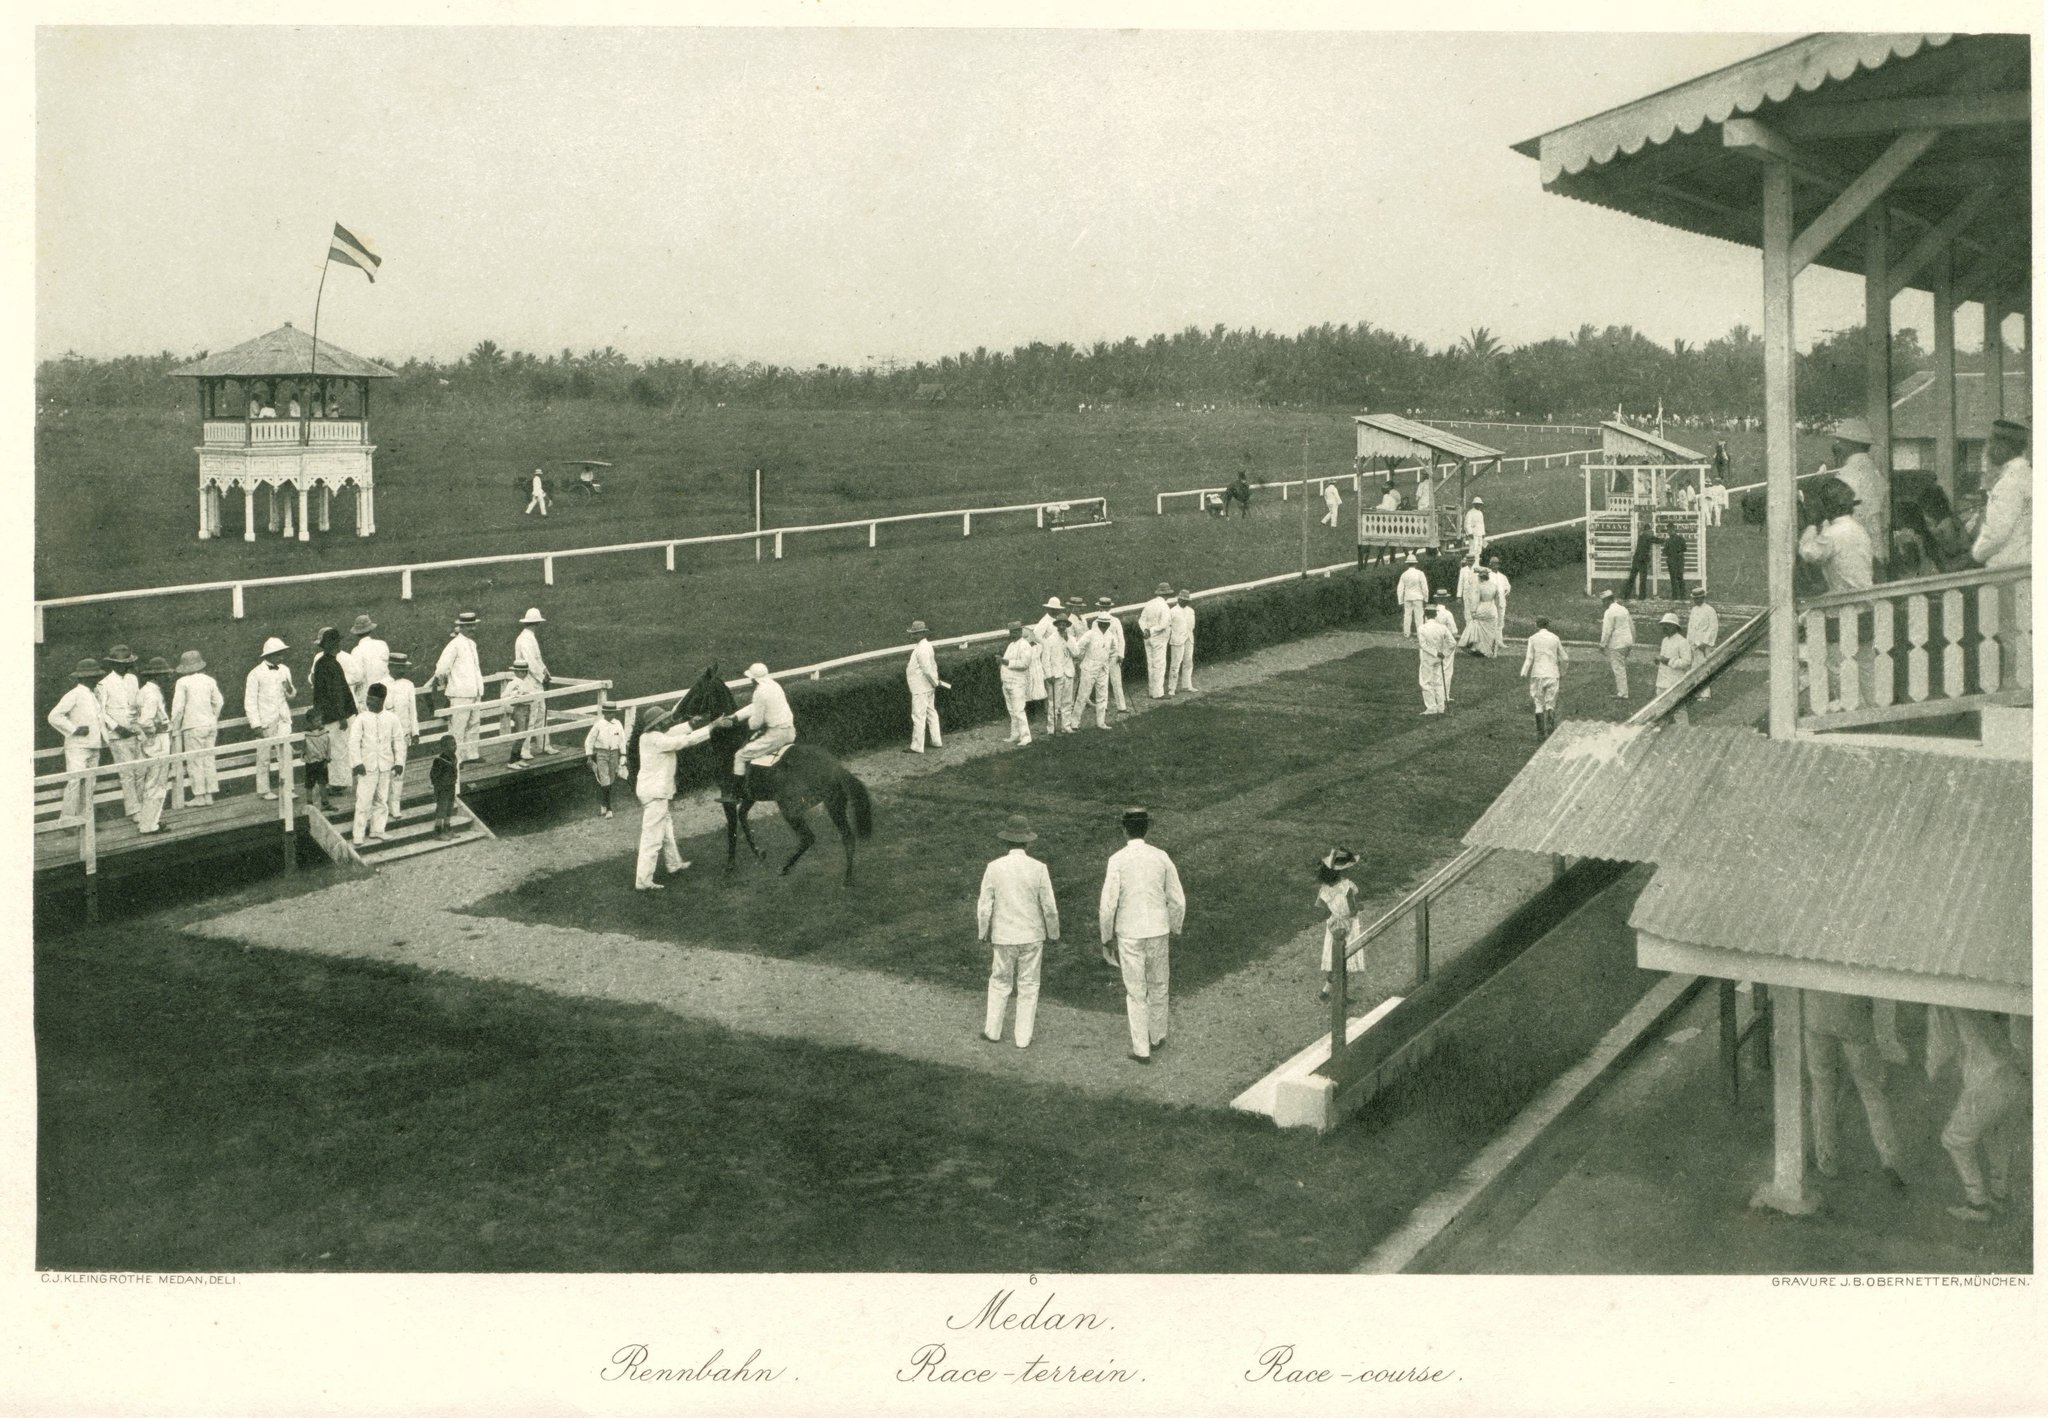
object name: photomechanical print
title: Gezicht op de renbaan in Medan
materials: paper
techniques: photoaquatint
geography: medan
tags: horse-racing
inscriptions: number: ‘6’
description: Onderdeel van Album met heliogravures van Sumatra's oostkust.